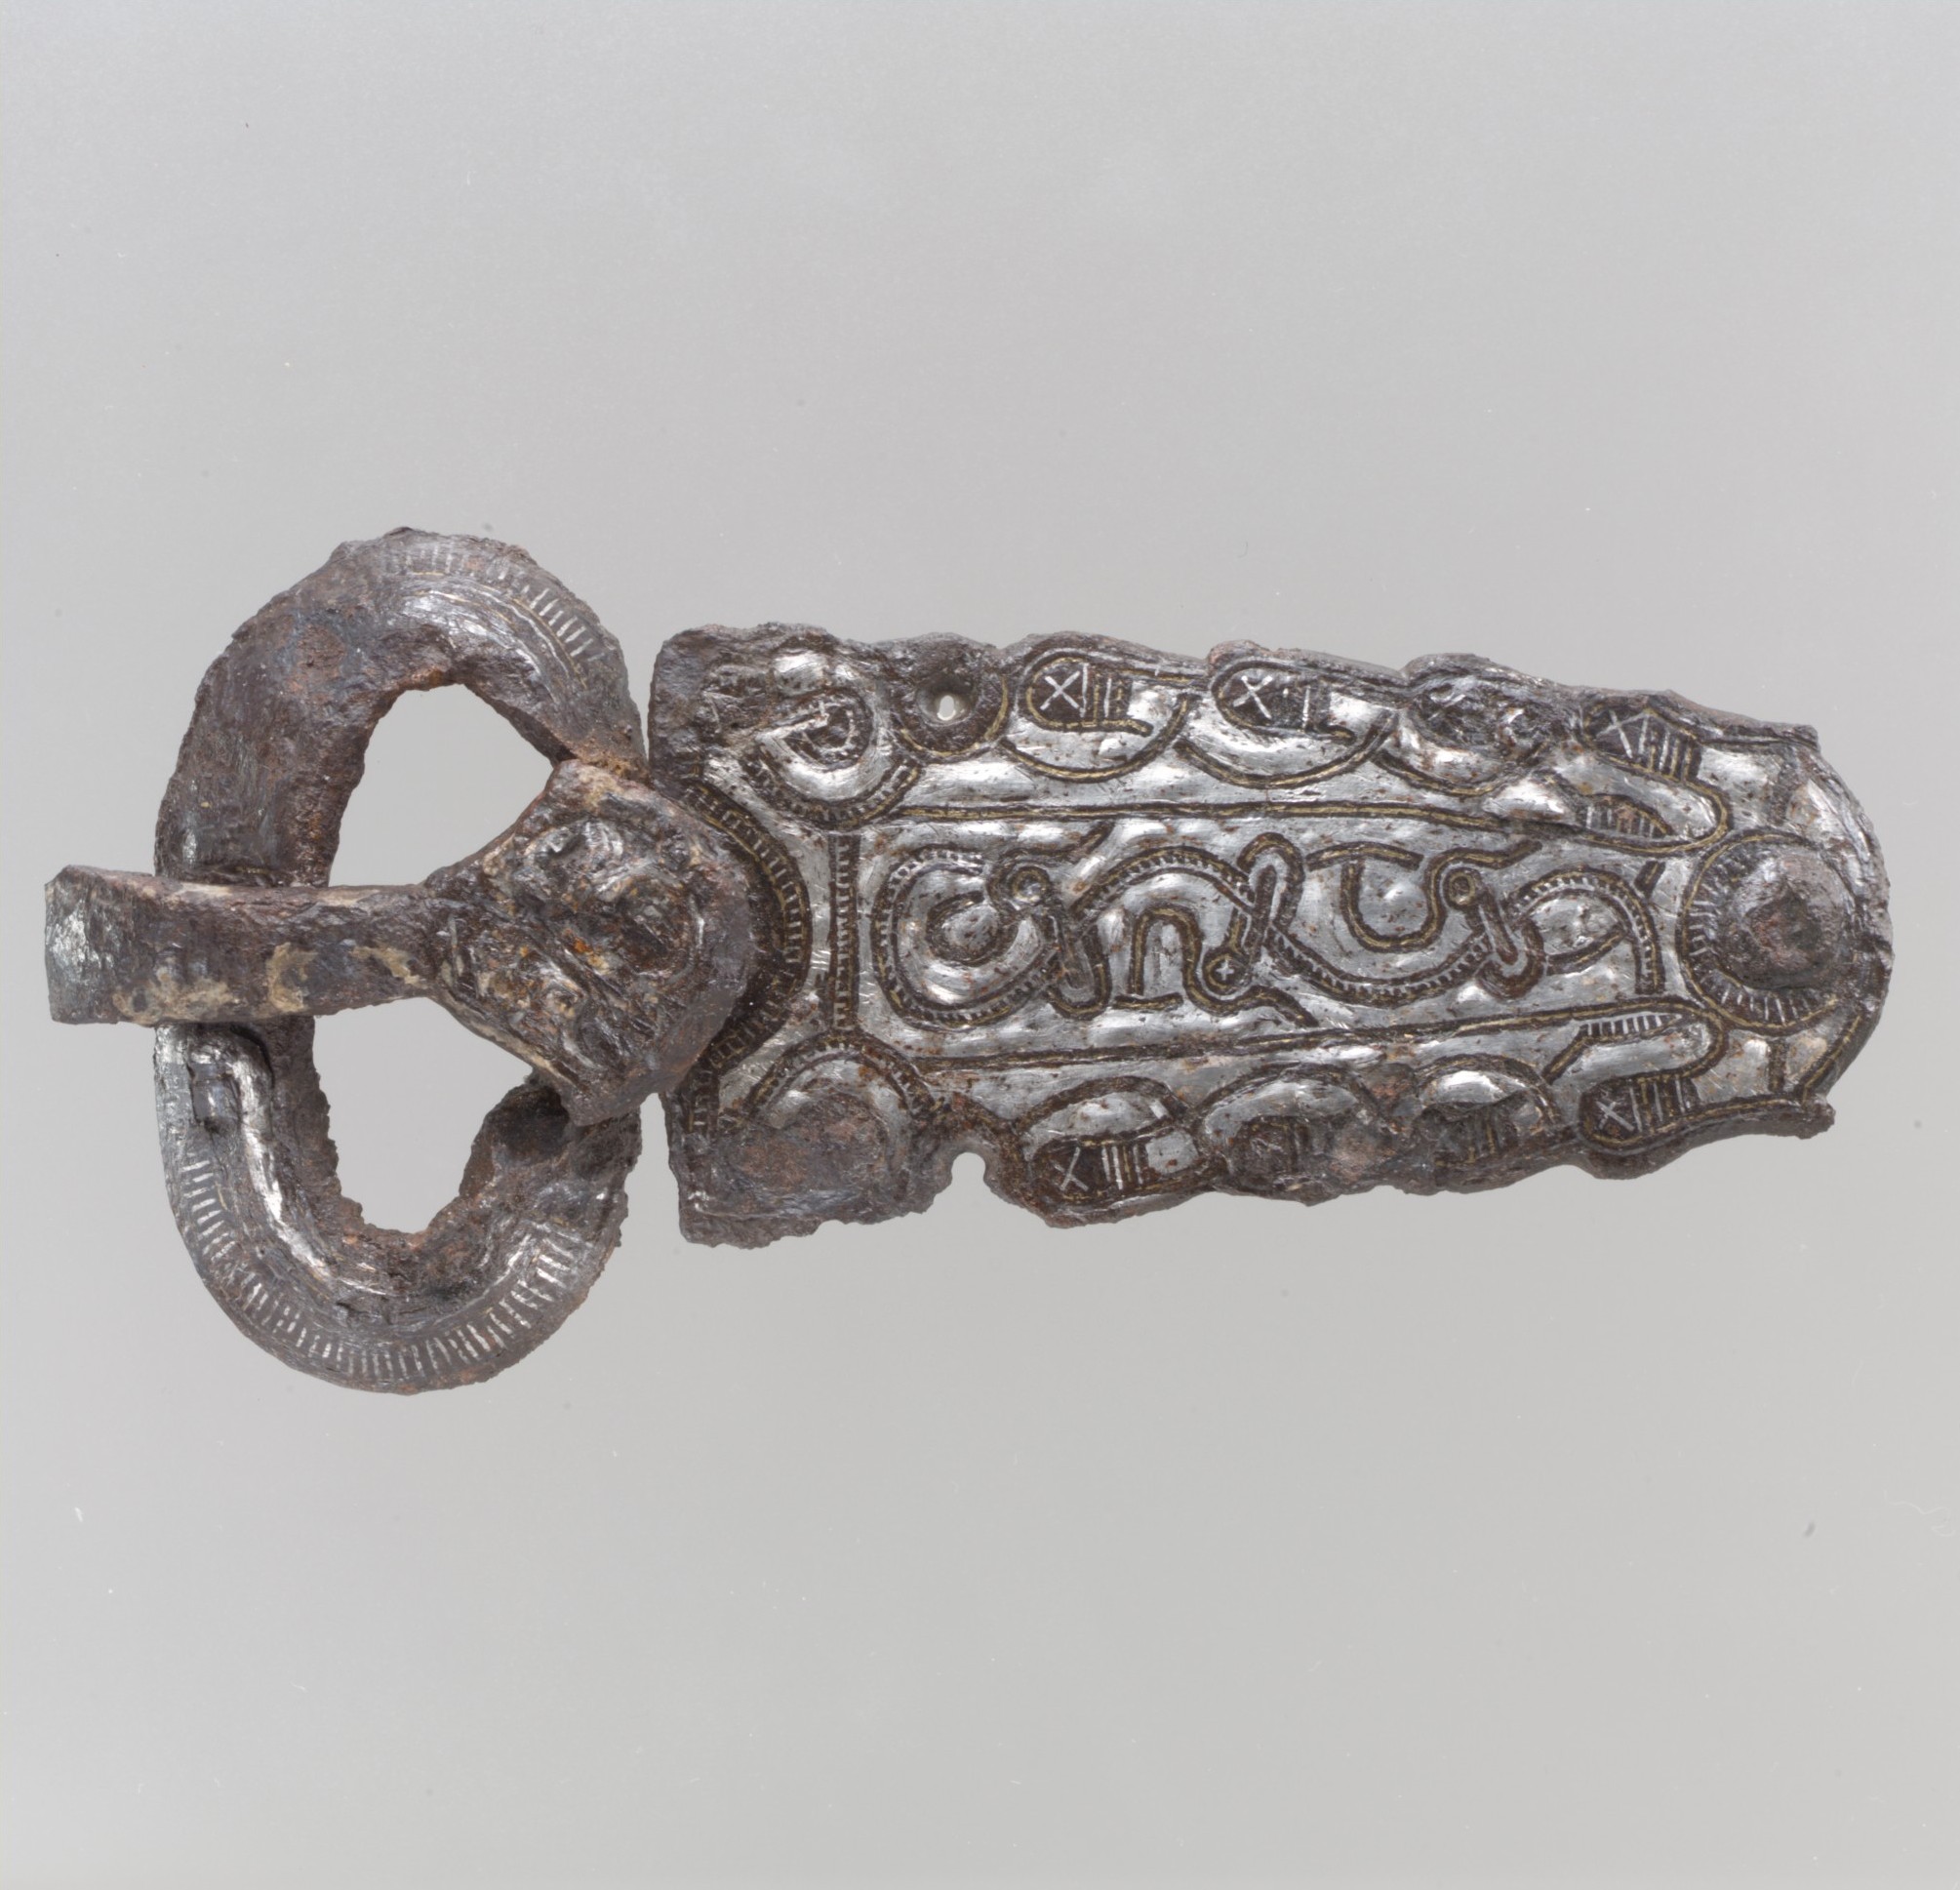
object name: belt buckle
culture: frankish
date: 601-700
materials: copper, iron, silver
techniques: inlay